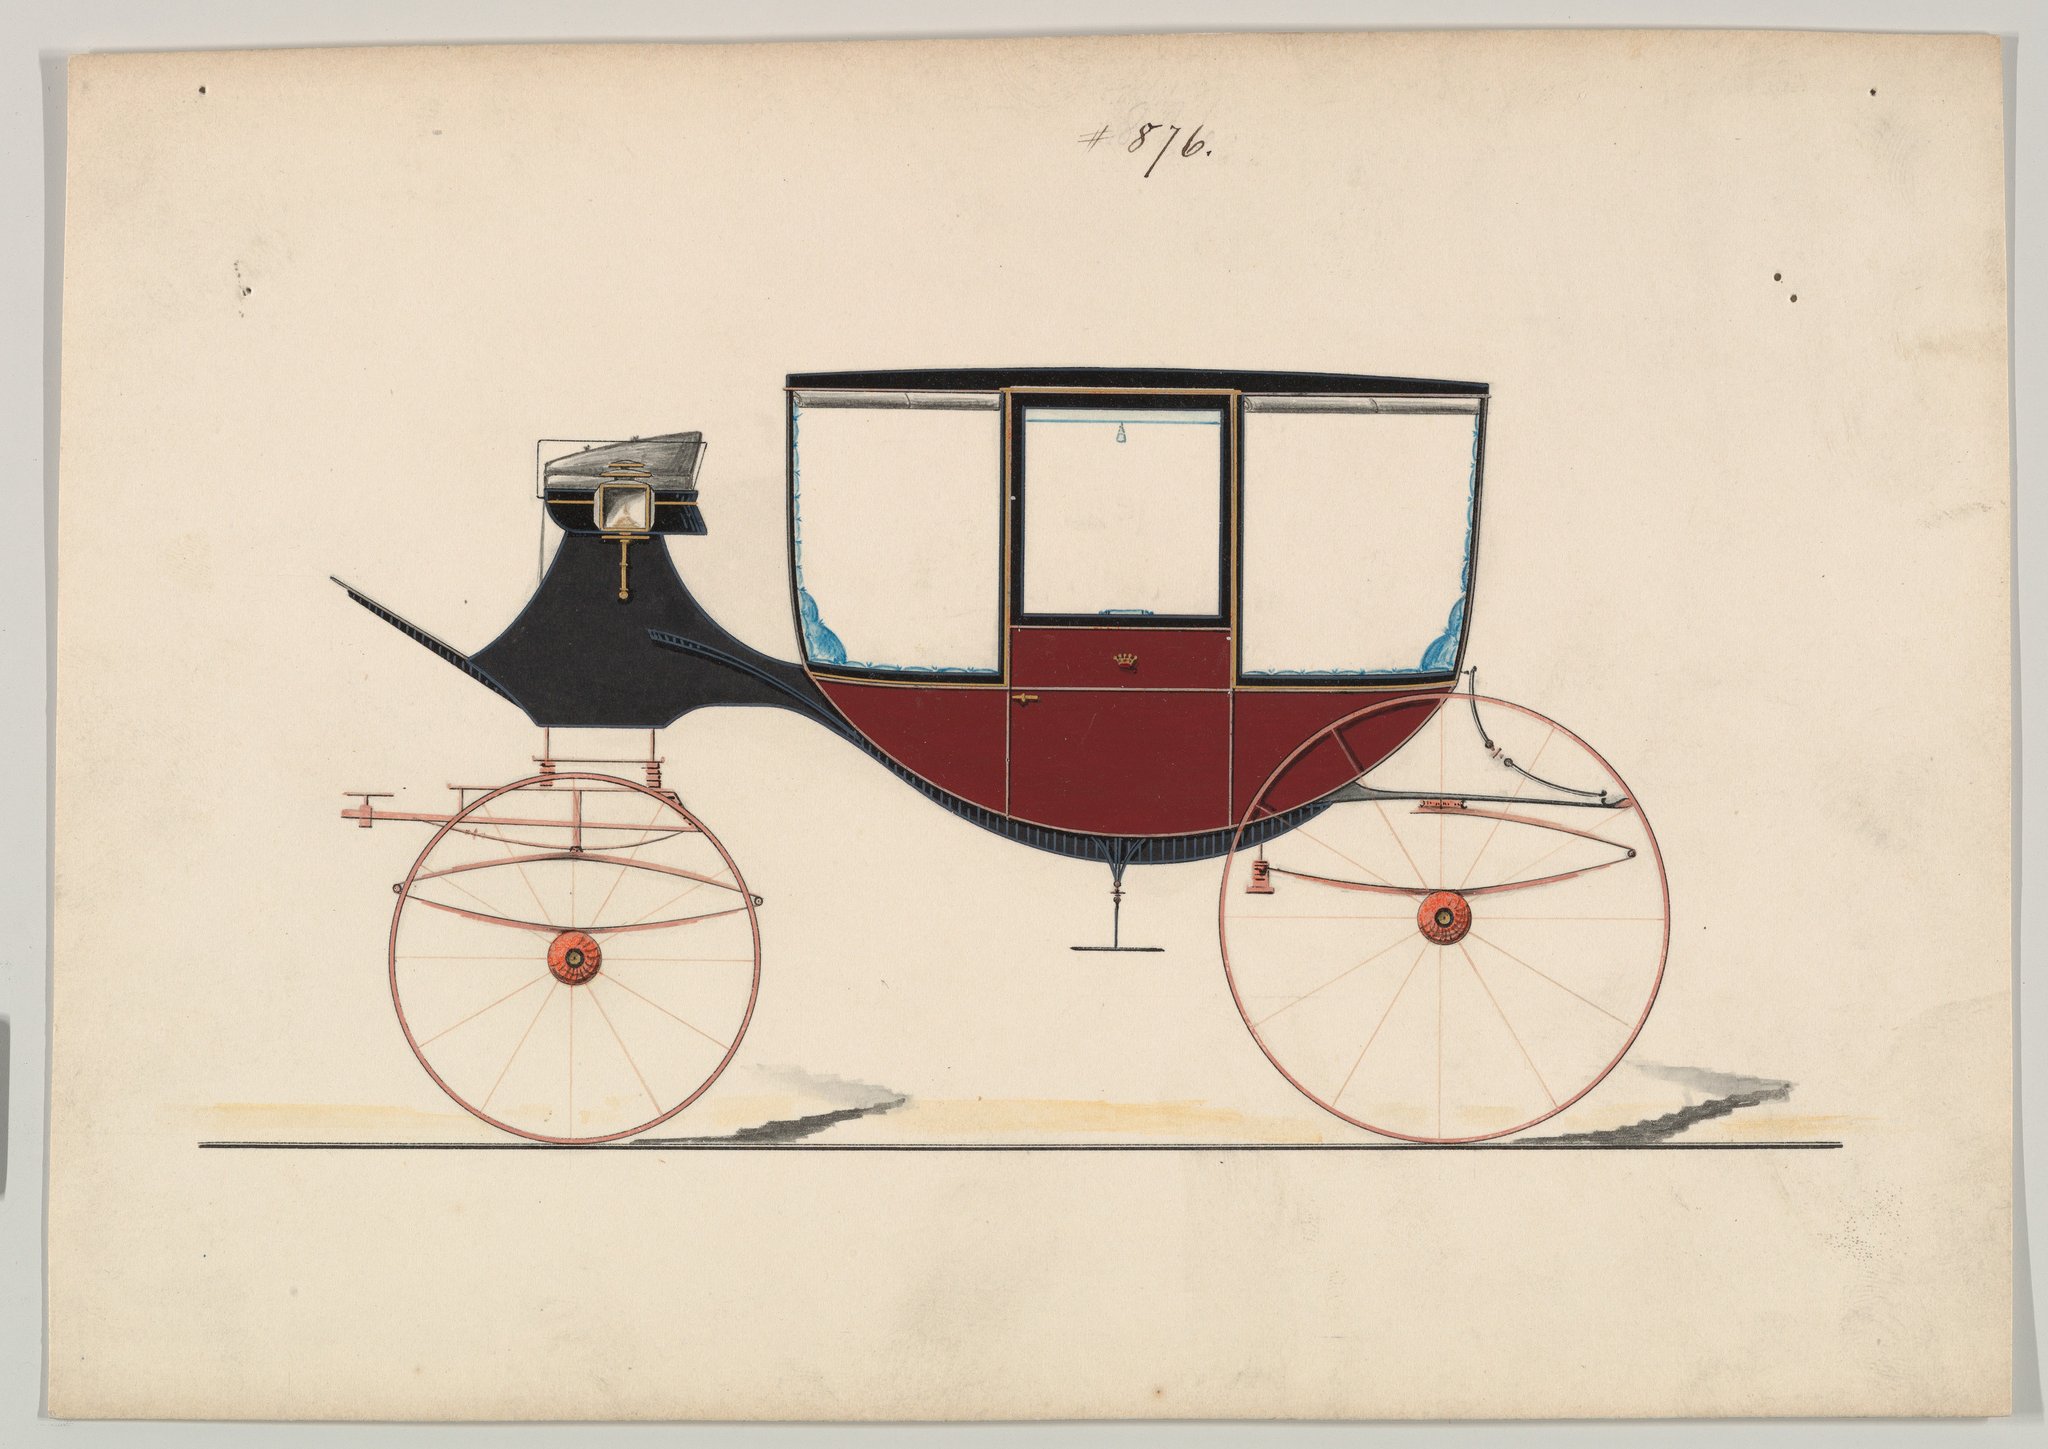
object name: drawing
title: Curtain Coach #876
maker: brewster & co.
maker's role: manufacturer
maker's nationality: american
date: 1870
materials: gouache, gum arabic, ink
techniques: pen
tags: carriages